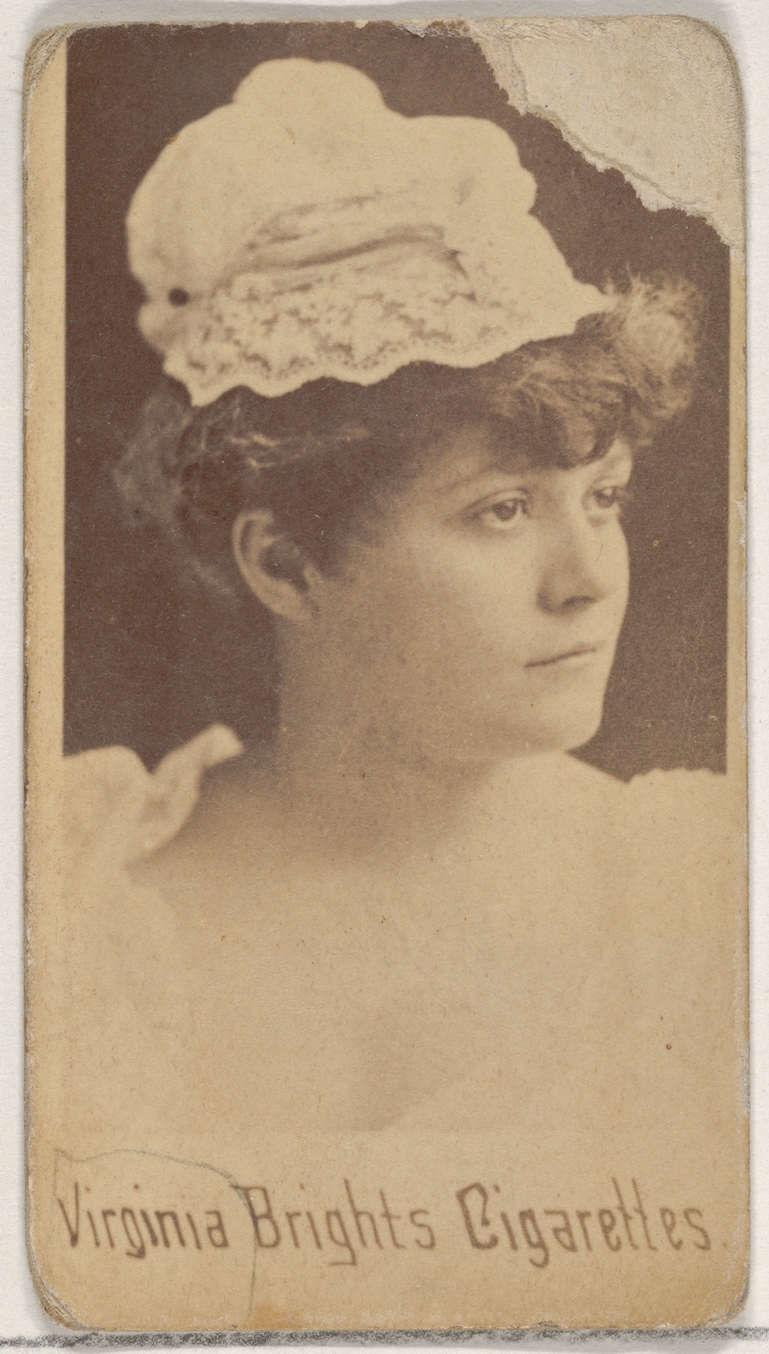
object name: photograph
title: From the Actors and Actresses series (N45, Type 5) for Virginia Brights Cigarettes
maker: allen & ginter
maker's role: publisher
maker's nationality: american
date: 1888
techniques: albumen silver print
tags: portraits,women,actresses